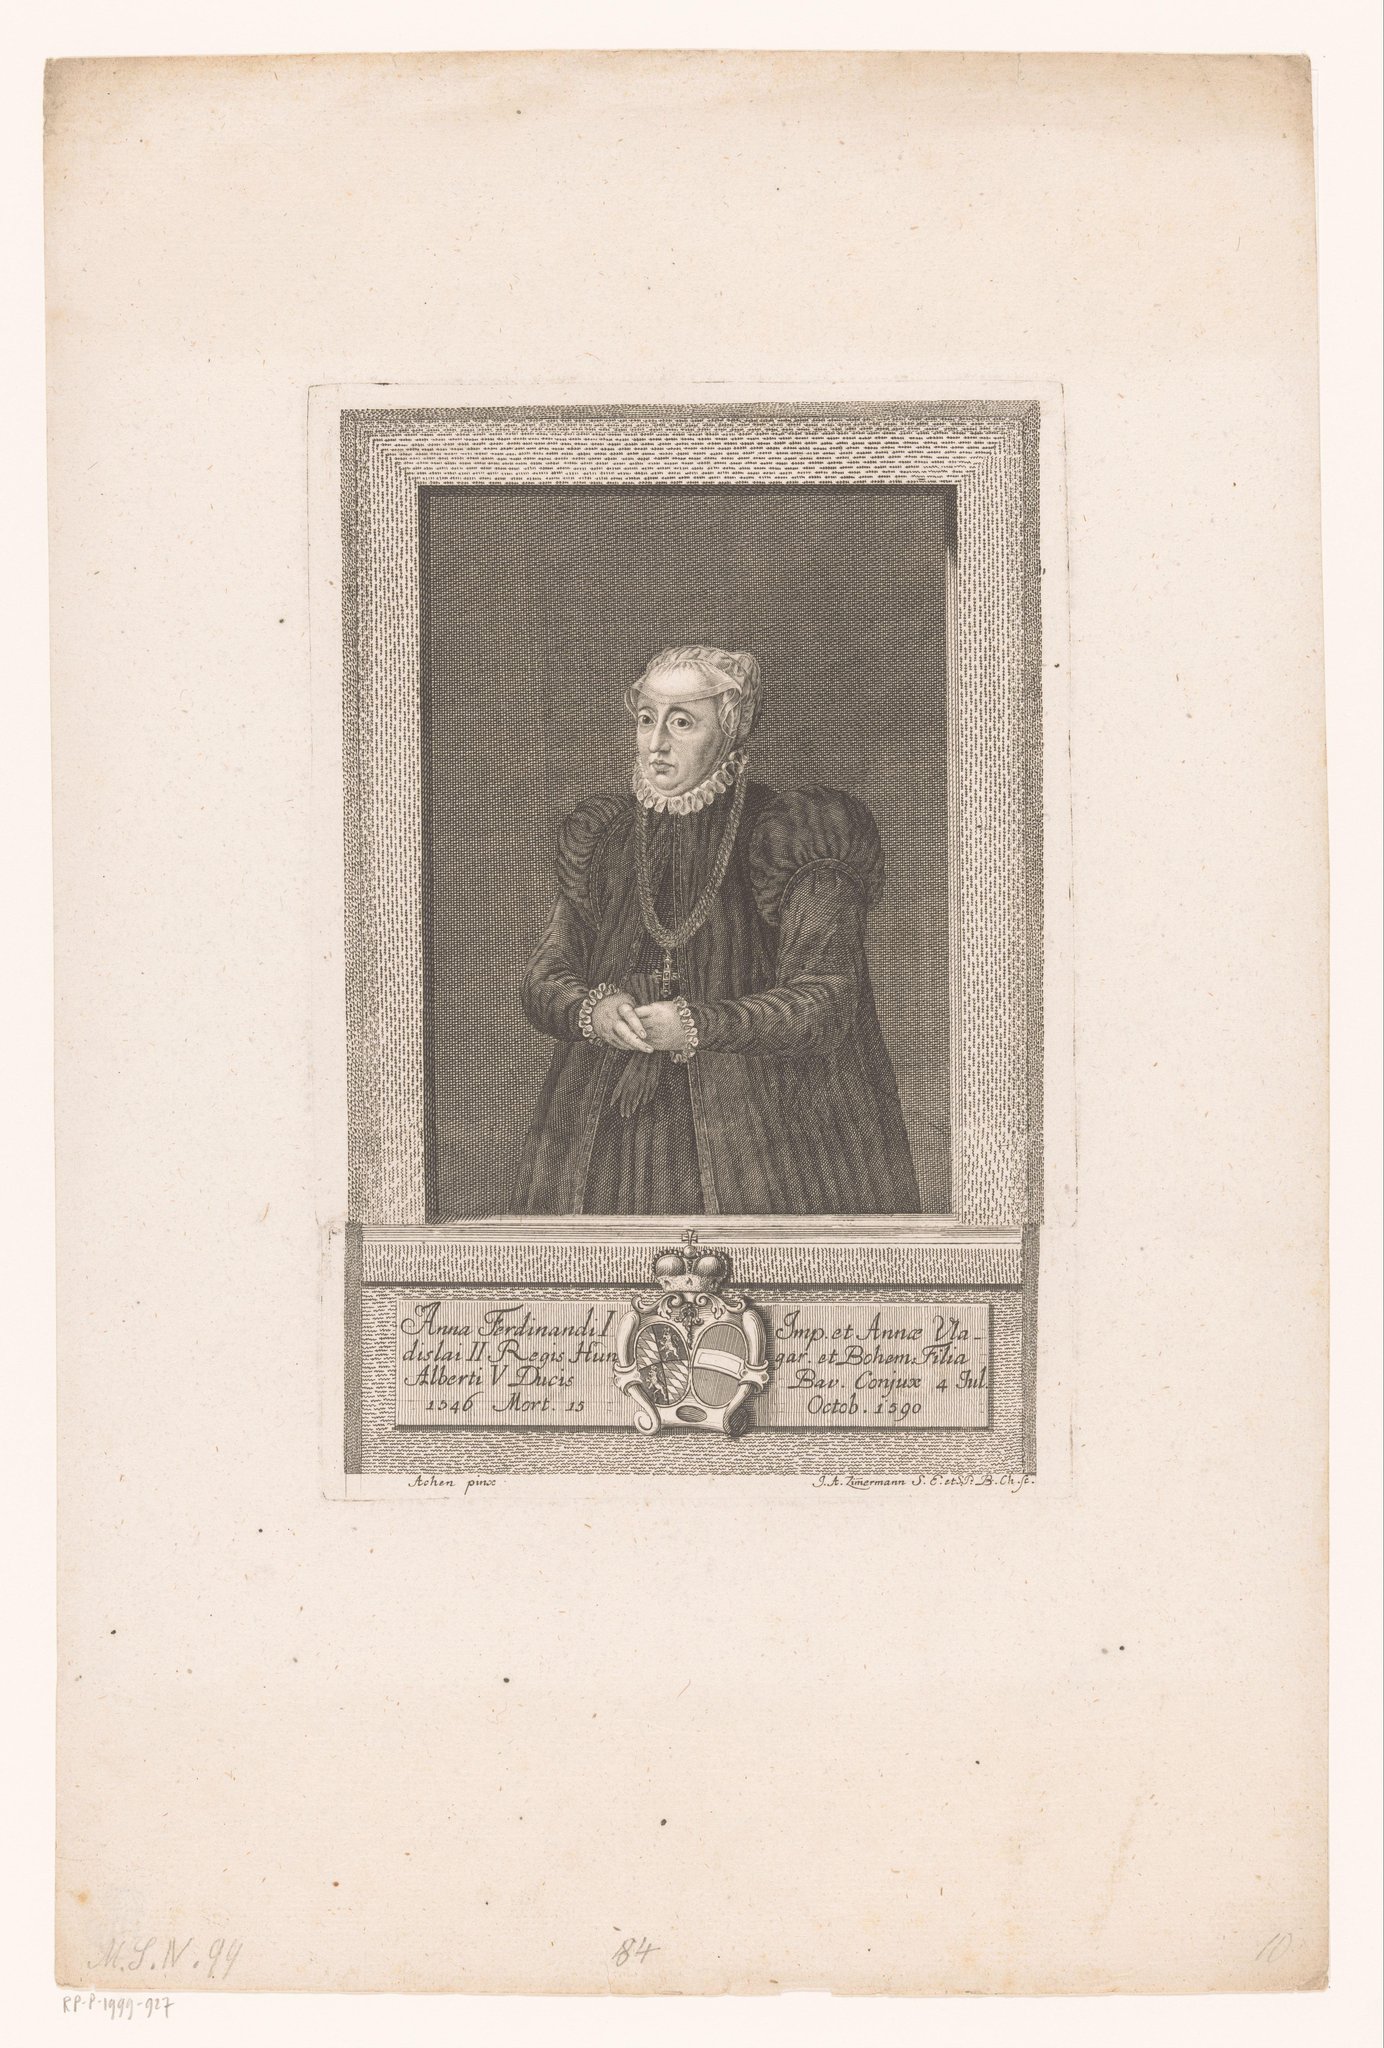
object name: print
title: Portret van Anna van Oostenrijk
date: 1773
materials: paper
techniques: engraving, etching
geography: germany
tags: historical persons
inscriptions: collector's mark: Lugt 4100, collector's mark: Lugt 2228, collector's mark: Lugt 2760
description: Prent gebruikt voor de publicatie: Zimmermann, Joseph Anton. Series Imaginum Augustae Domus Boicae. München: s.n., 1773.